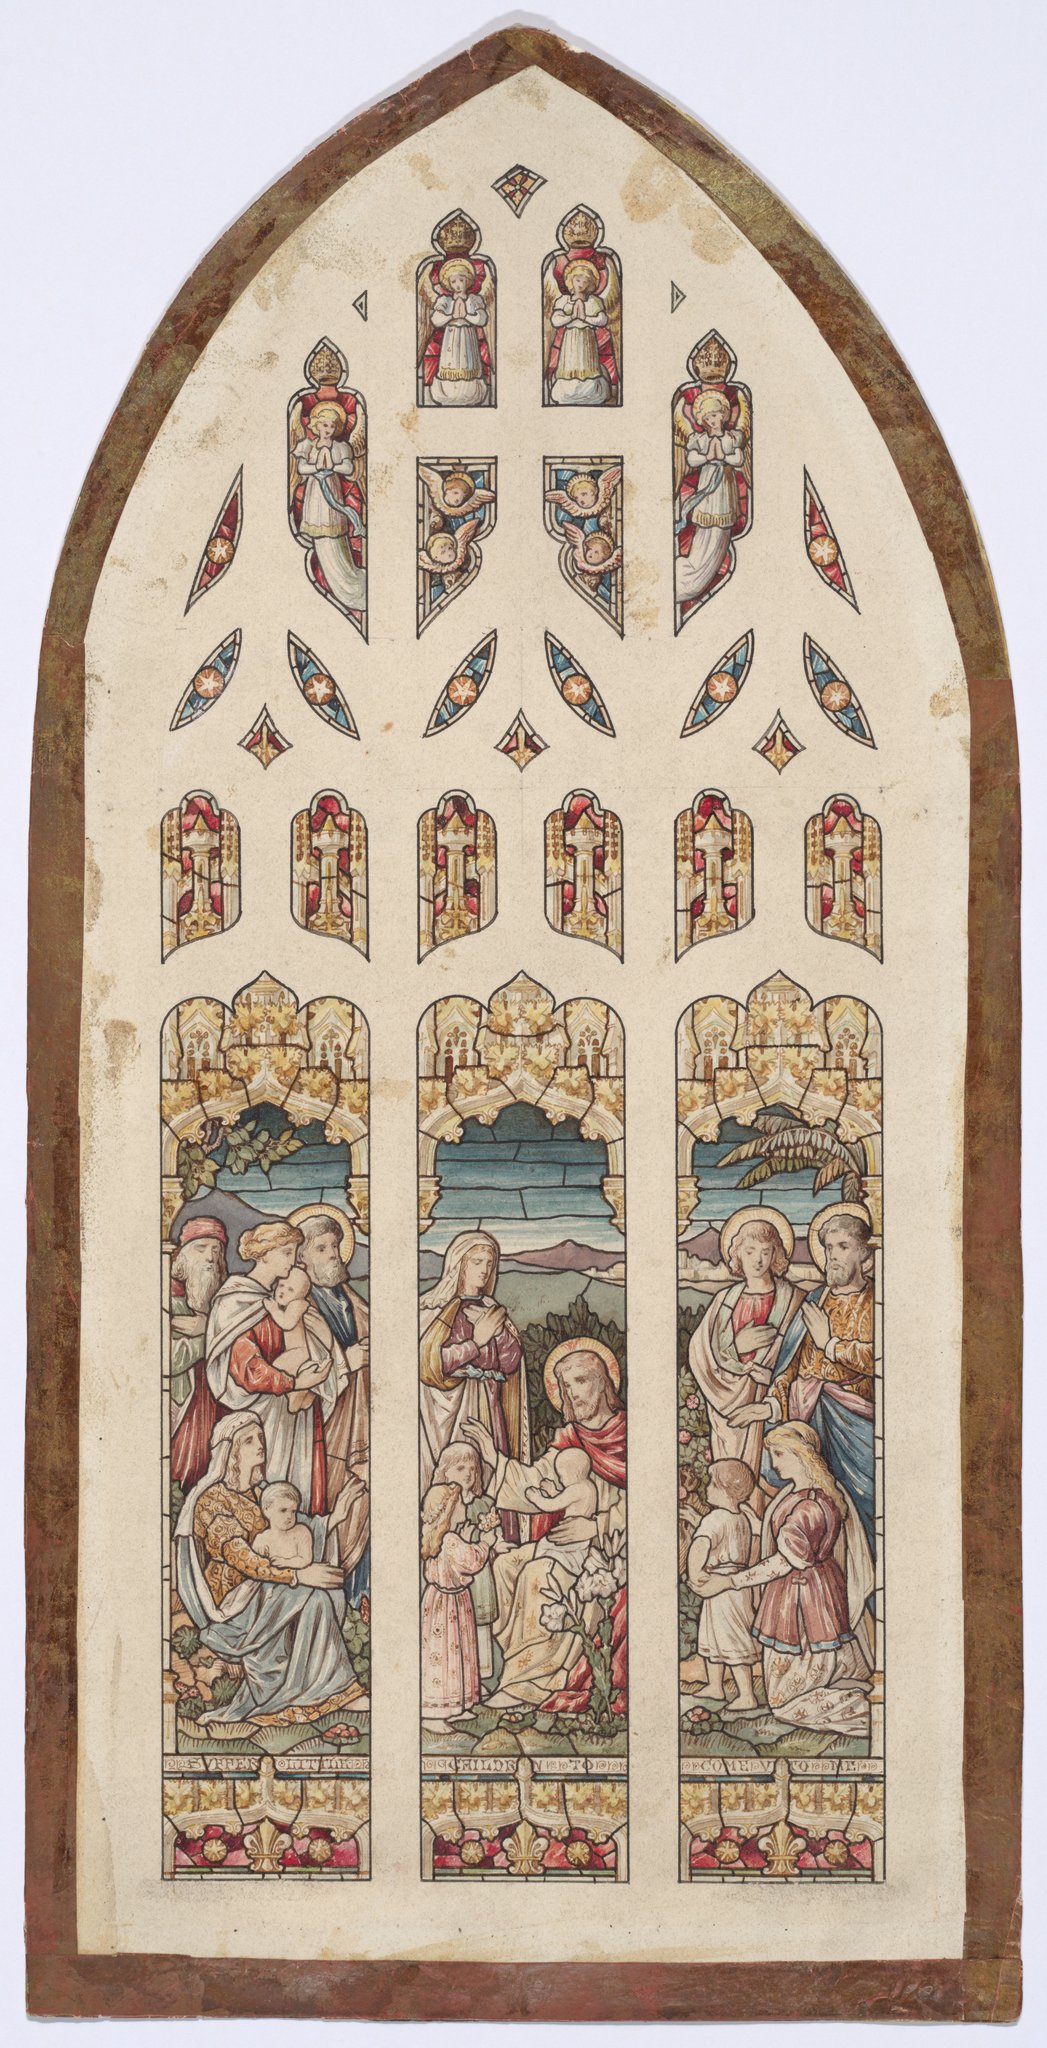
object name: drawing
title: Design for a stained glass window with Jesus Blessing the Little Children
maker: anonymous, british, 19th century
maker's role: artist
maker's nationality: british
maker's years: 1800-1900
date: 1801-1900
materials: graphite, ink, watercolor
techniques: pen